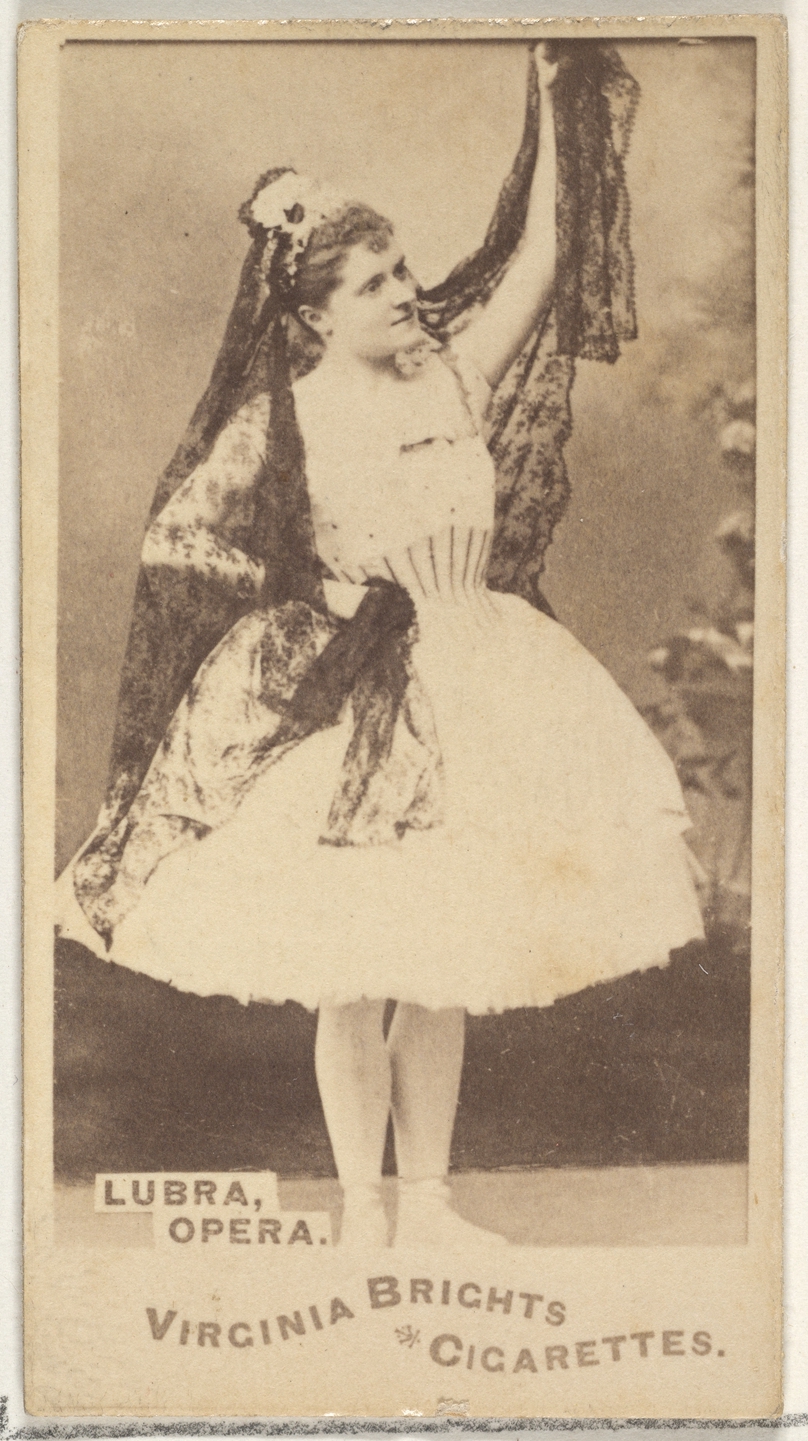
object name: photograph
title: Lubra, Opera, from the Actors and Actresses series (N45, Type 1) for Virginia Brights Cigarettes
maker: allen & ginter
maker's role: publisher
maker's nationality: american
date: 1888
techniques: albumen silver print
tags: portraits,women,actresses